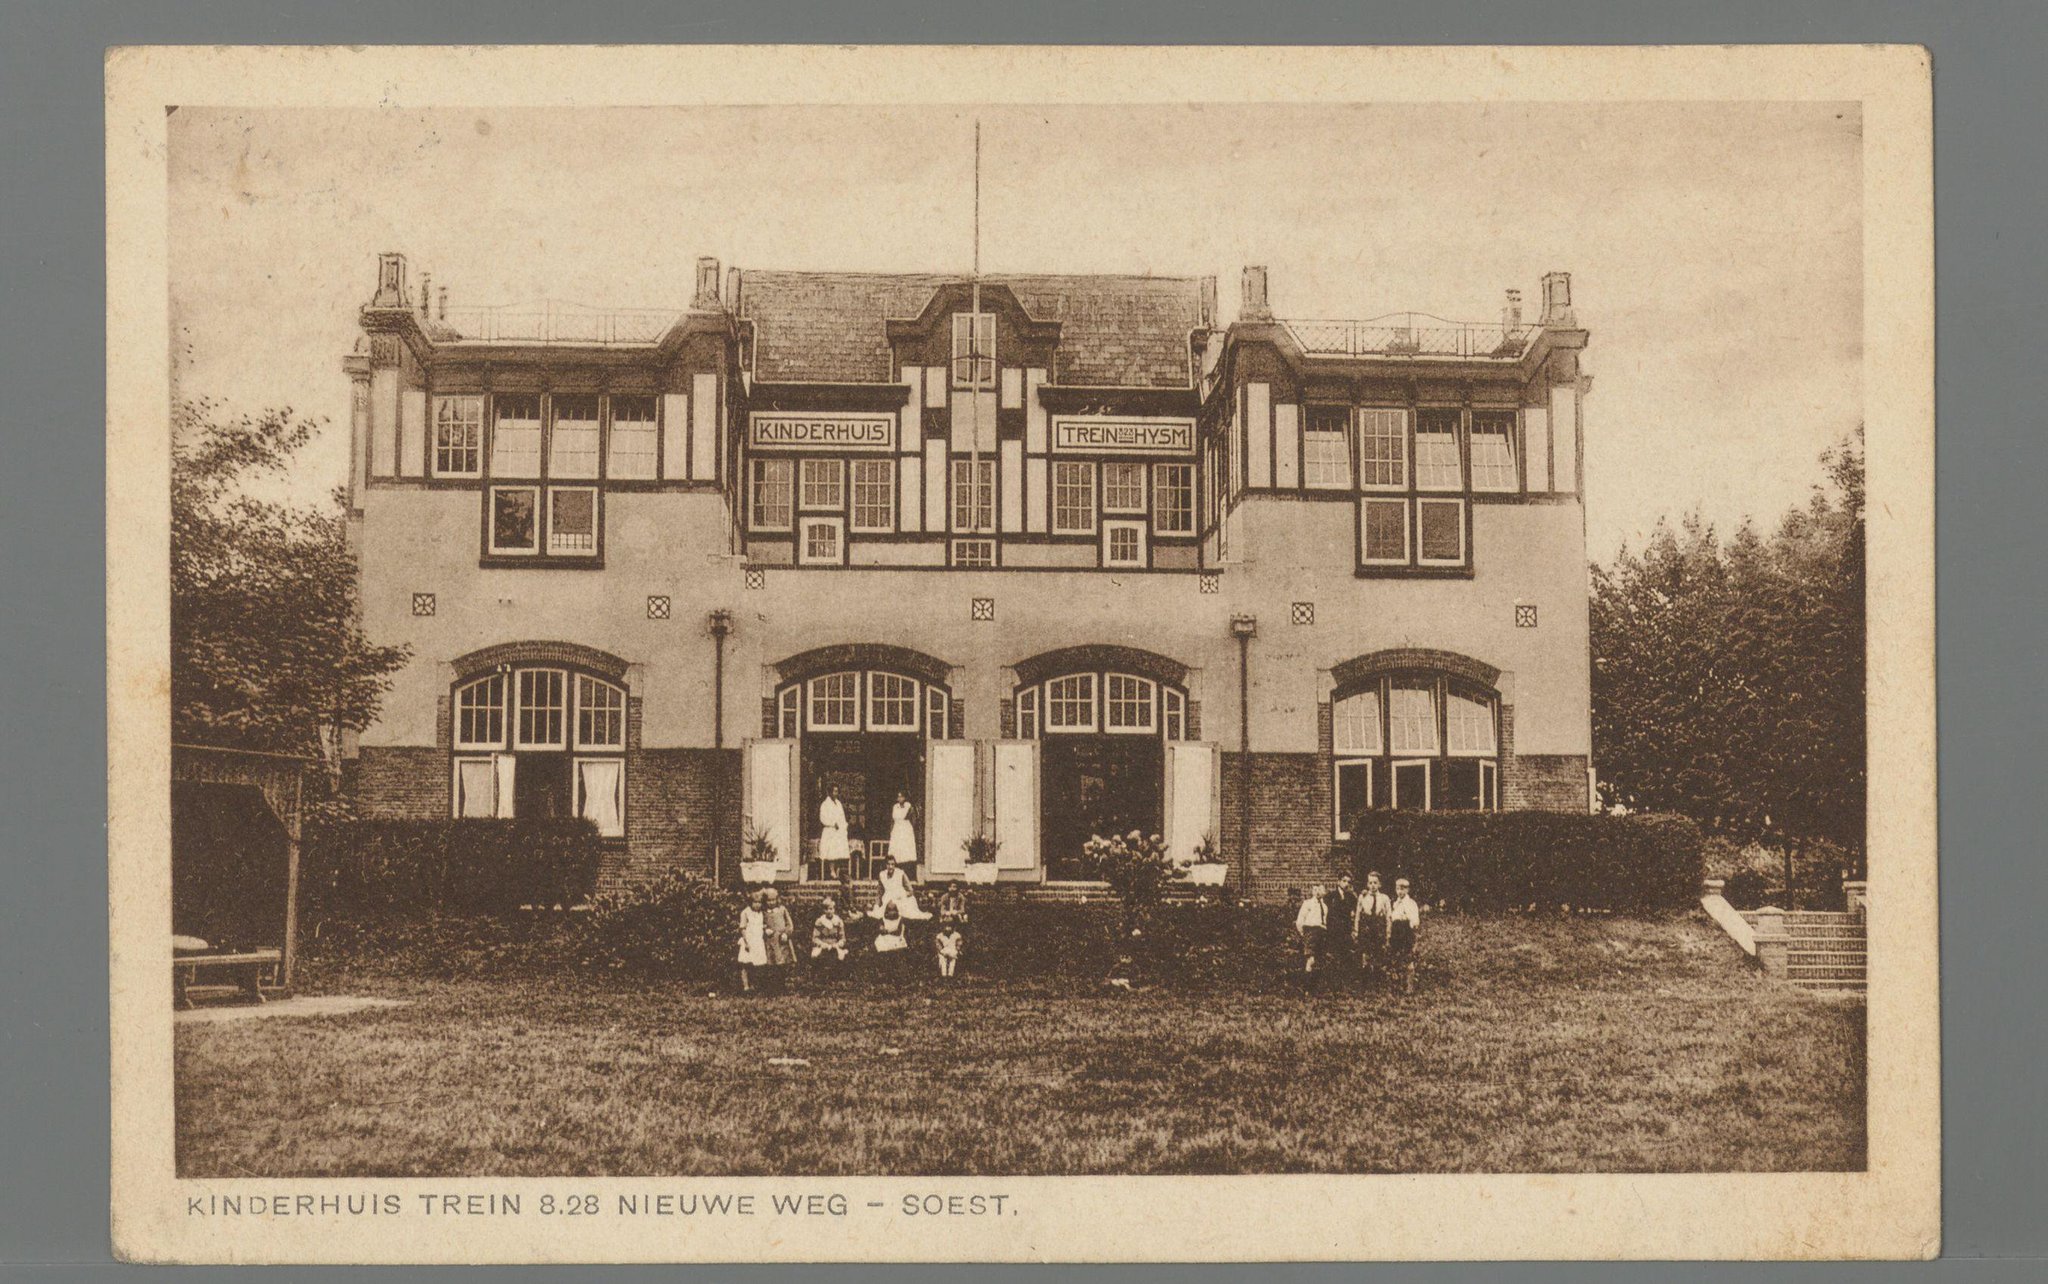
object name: ansichtkaart, prentbriefkaart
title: Kinderhuis Trein 8.28 Nieuwe Weg - Soest.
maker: Anonymous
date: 1923-1929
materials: cardboard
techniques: photograph, writing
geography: baarn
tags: hospital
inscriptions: postage stamp